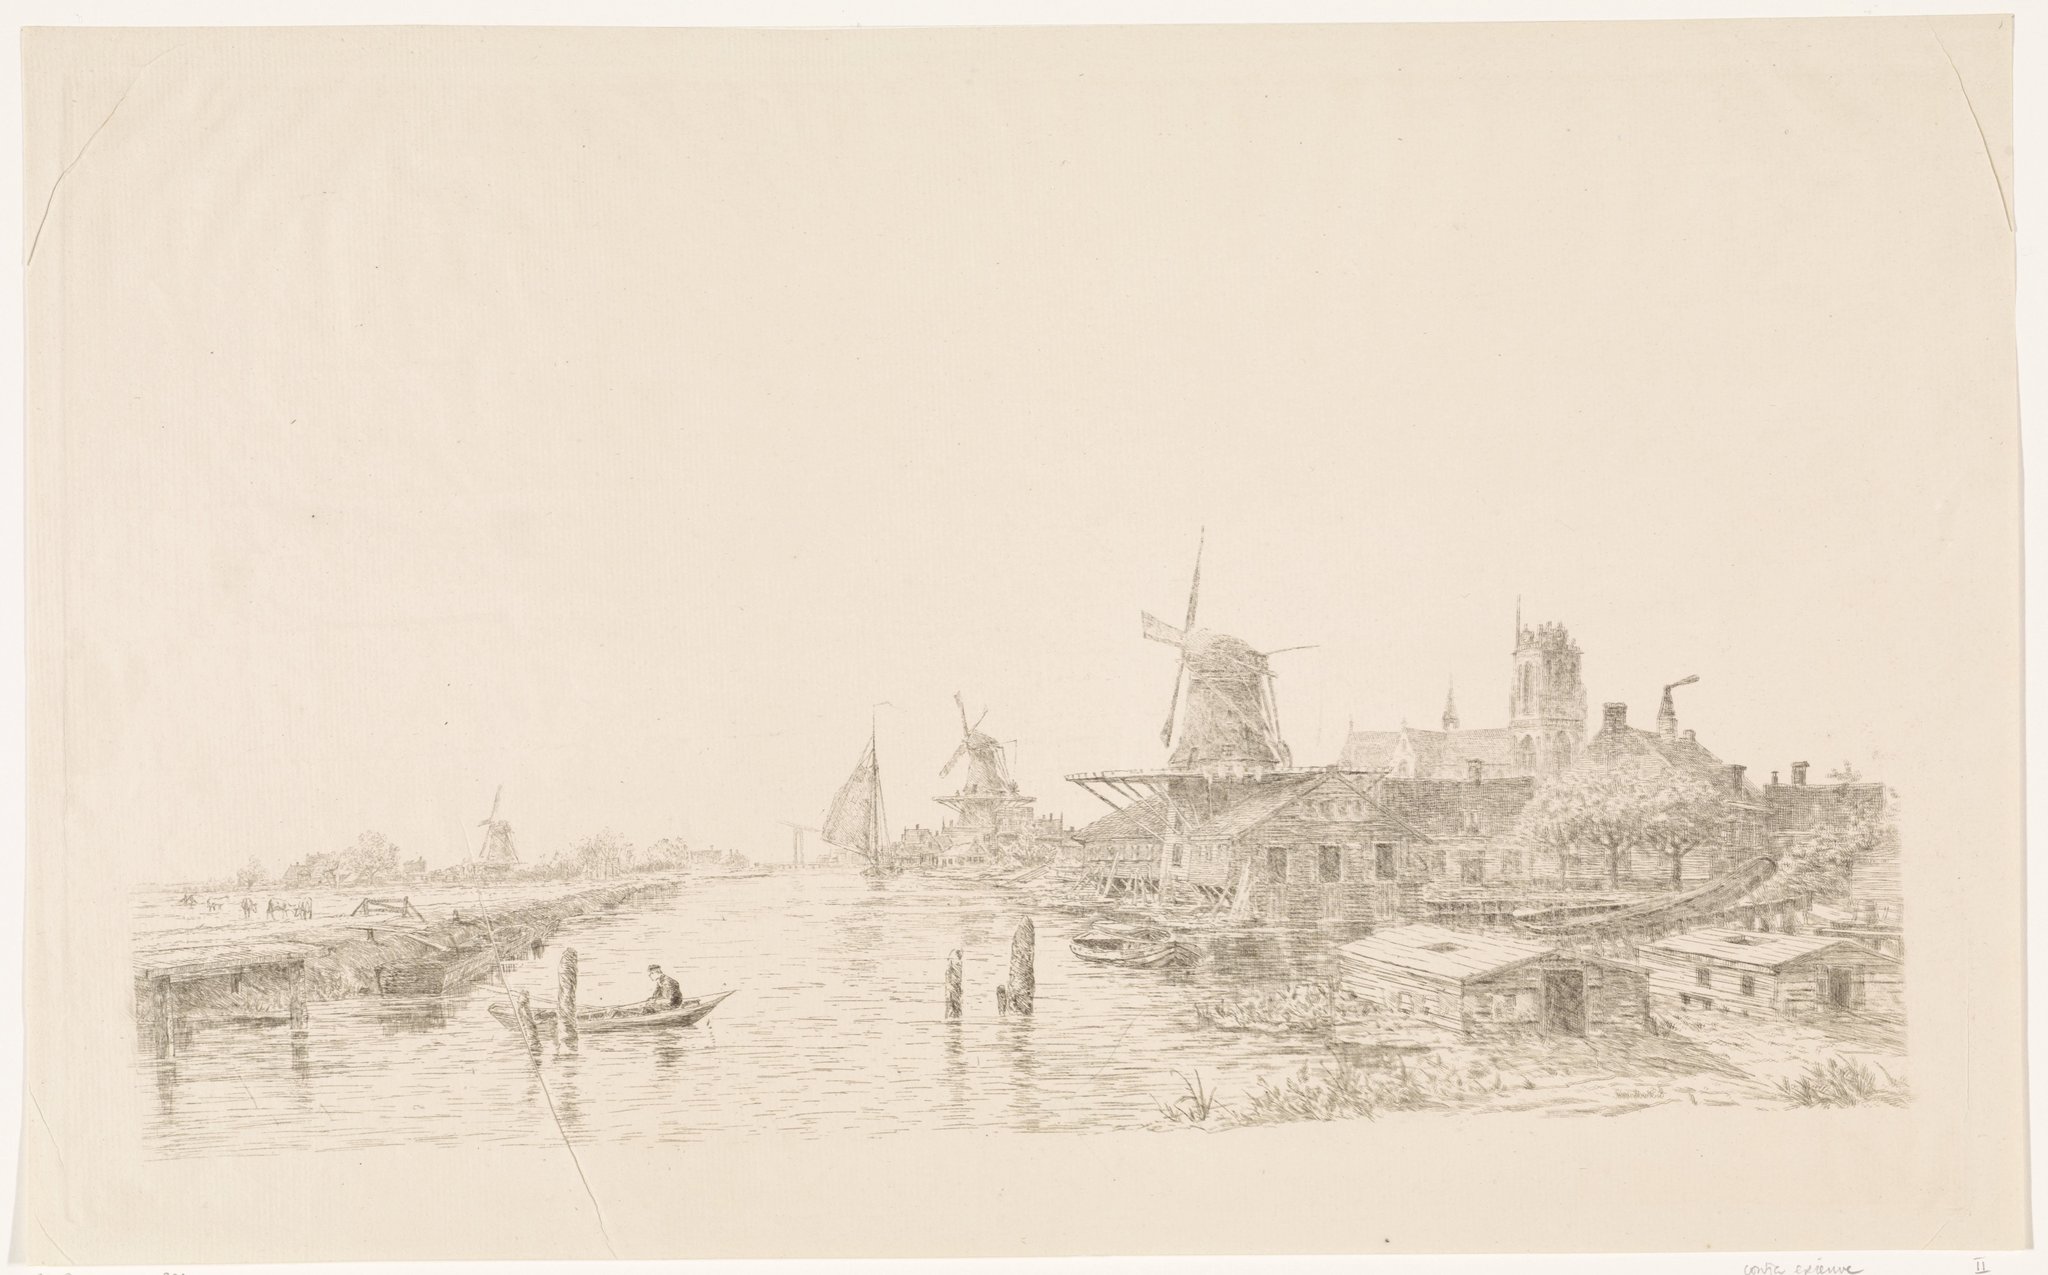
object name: print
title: Rivierlandschap met dorp en houtzaagmolen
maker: elias stark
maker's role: draughtsman, print maker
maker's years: 1849-1933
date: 1888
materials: paper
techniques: printmaking, etching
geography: nieuwer-amstel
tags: river, windmill in landscape, angling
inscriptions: collector's mark: Lugt 2228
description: Zicht op een rivier met rechts een dorp met kerk en een houtzaagmolen. Op het water een visser in een schuit en op de achtergrond een zeilschip.